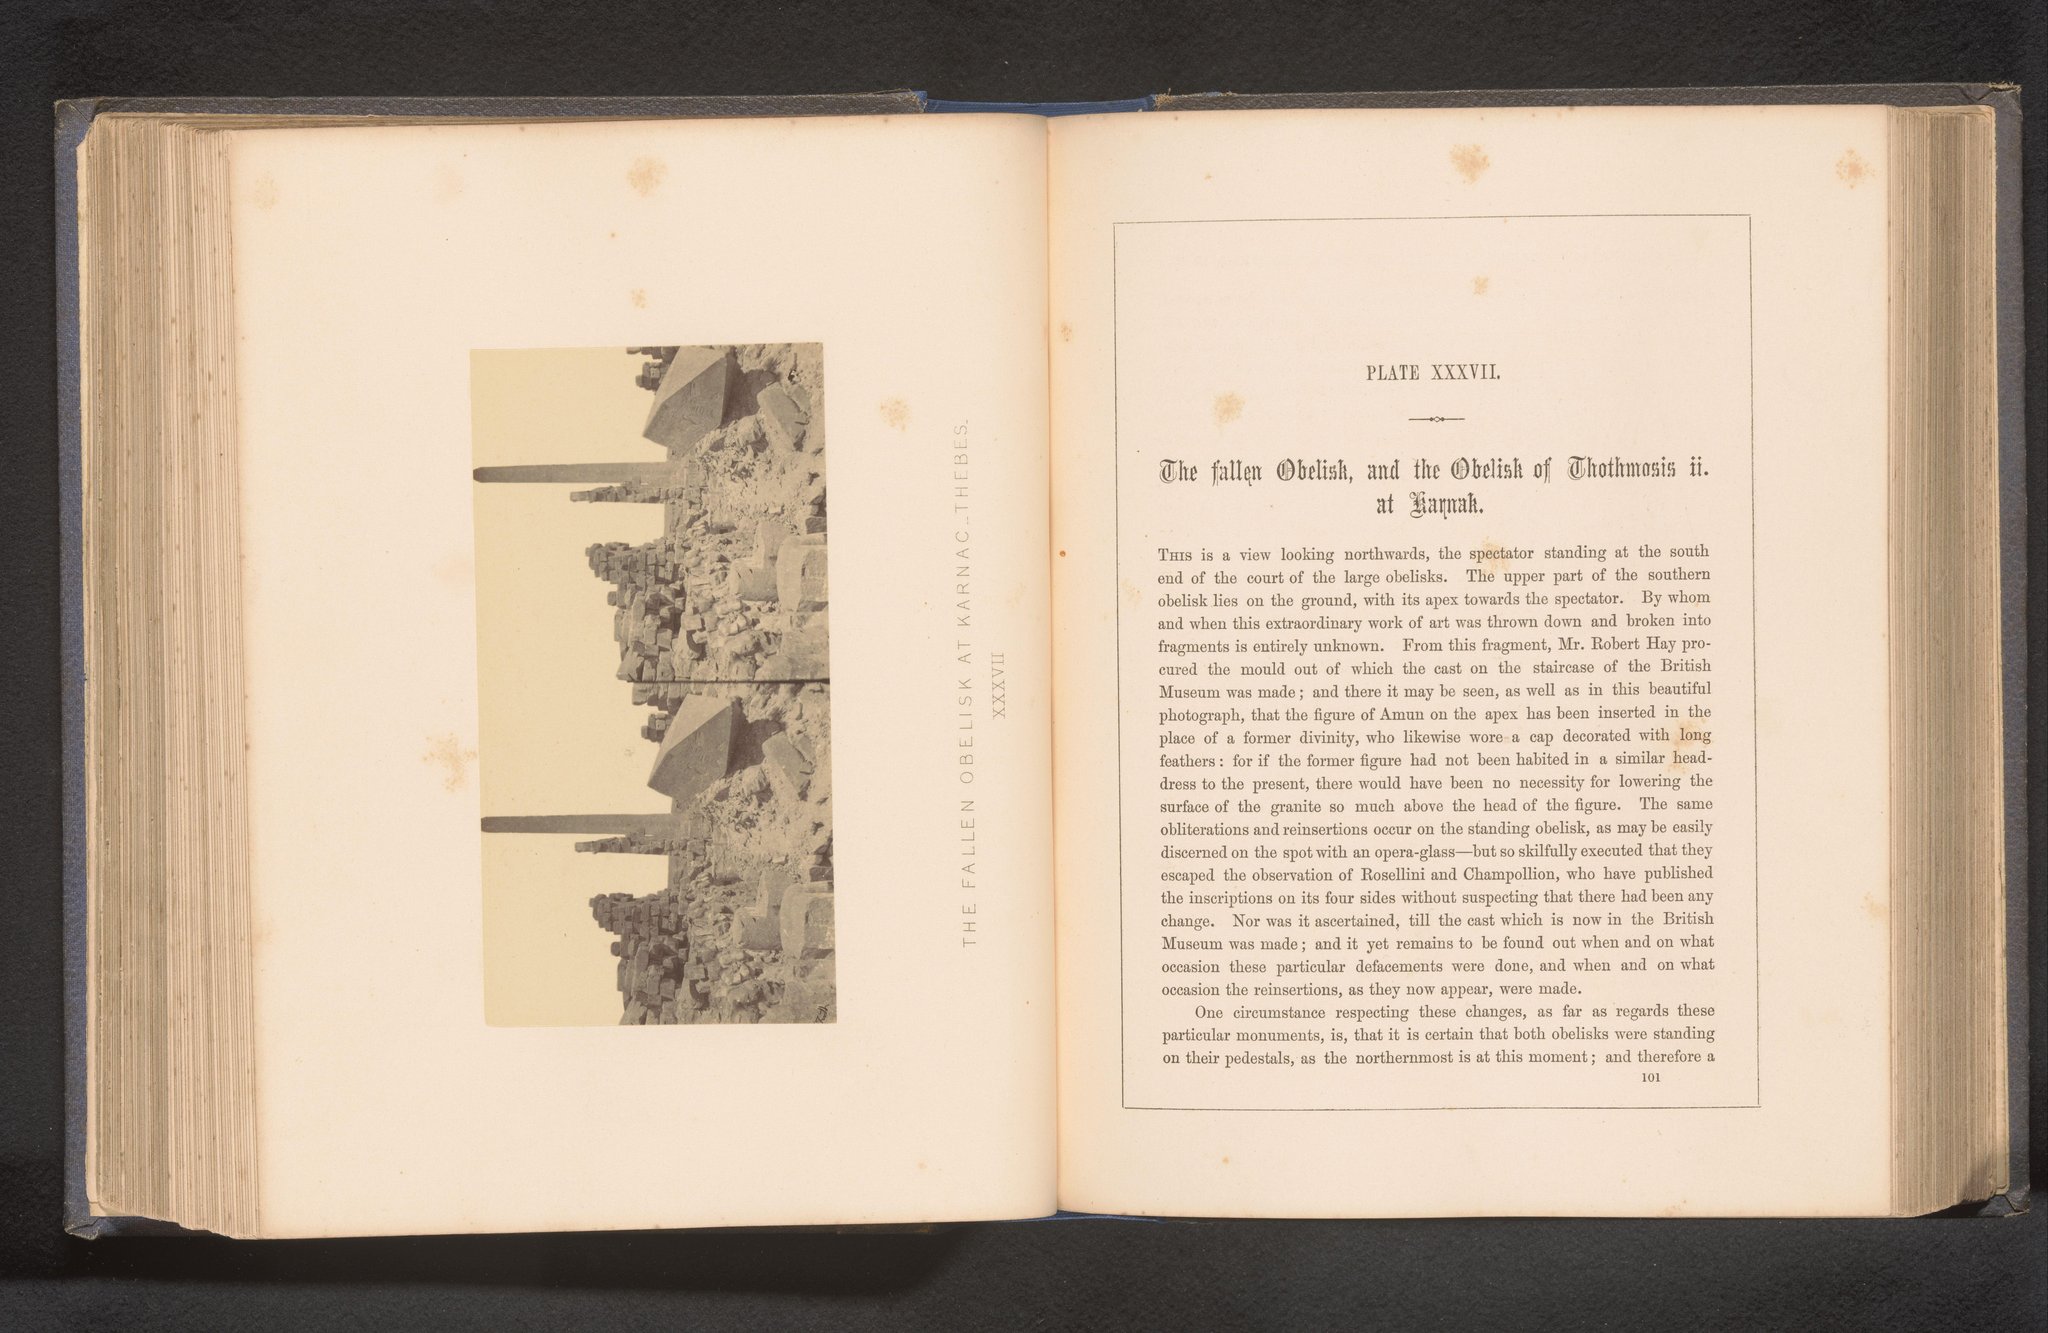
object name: stereograph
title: Gevallen obelisk en de obelisk van Thoetmosis II bij het tempelcomplex te Karnak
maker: francis frith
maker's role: publisher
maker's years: 1822-1898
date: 1857-1862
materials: photographic support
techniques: albumen print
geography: karnak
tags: obelisk, needle, ruin of a building ~ architecture, egyptian hieroglyphs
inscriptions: number: ‘XXXVII’, name: ‘Frith’